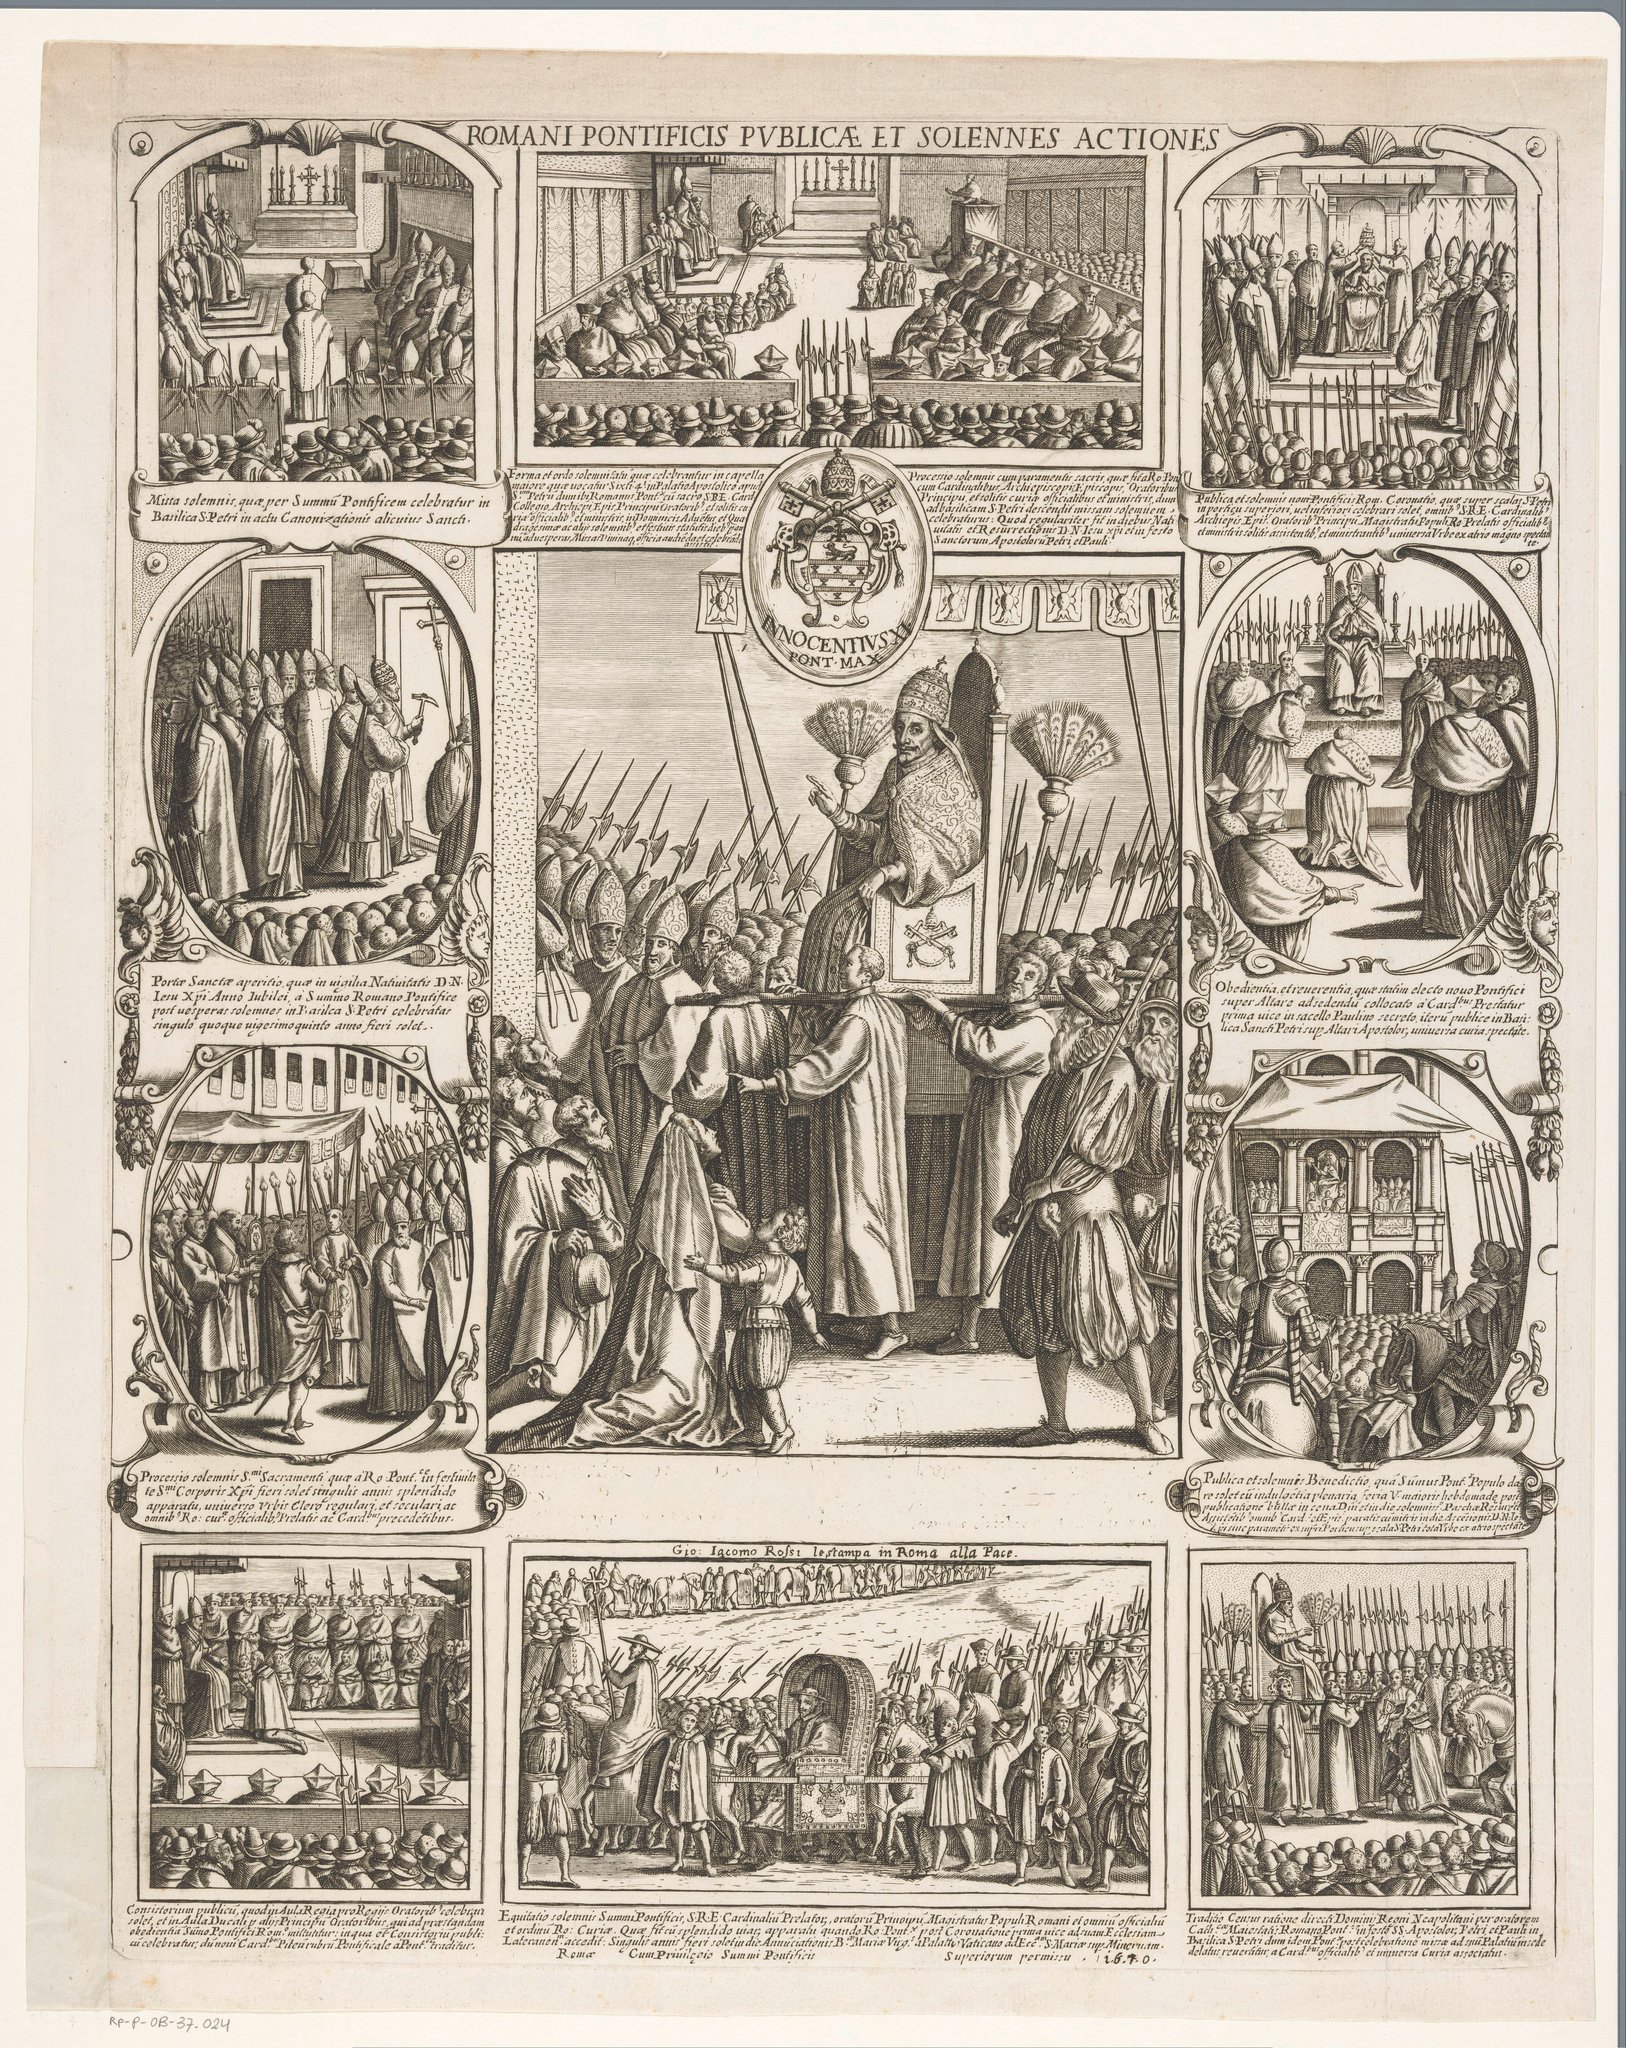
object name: print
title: Daden en handelingen van paus Innocentius XI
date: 1676-1689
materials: paper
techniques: engraving, etching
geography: rome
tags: rome, clergyman, innocentius xi, ceremonial procession, parade, pageant ~ pope, interior of church, pope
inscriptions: collector's mark: Lugt 2228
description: Van deze prent zijn verschillende staten bekend, van verschillende pausen. De plaat werd telkens aangepast: Eerste bekende staat: paus Alexander VII, gedateerd 1655. Tweede bekende staat: paus Clemens IX, gedateerd 1667. Derde bekende staat: paus Clemens X, gedateerd 1670. Vierde (huidige) bekende staat: paus Innocentius XI, datering is hier niet aangepast waardoor er nog de datering van de vorige staat op staat (1670), die dus niet klopt. Moet uitgegeven zijn in de periode waarin hij paus was (1676-1689). Vijfde bekende staat: paus Alexander VIII, gedateerd 1689.